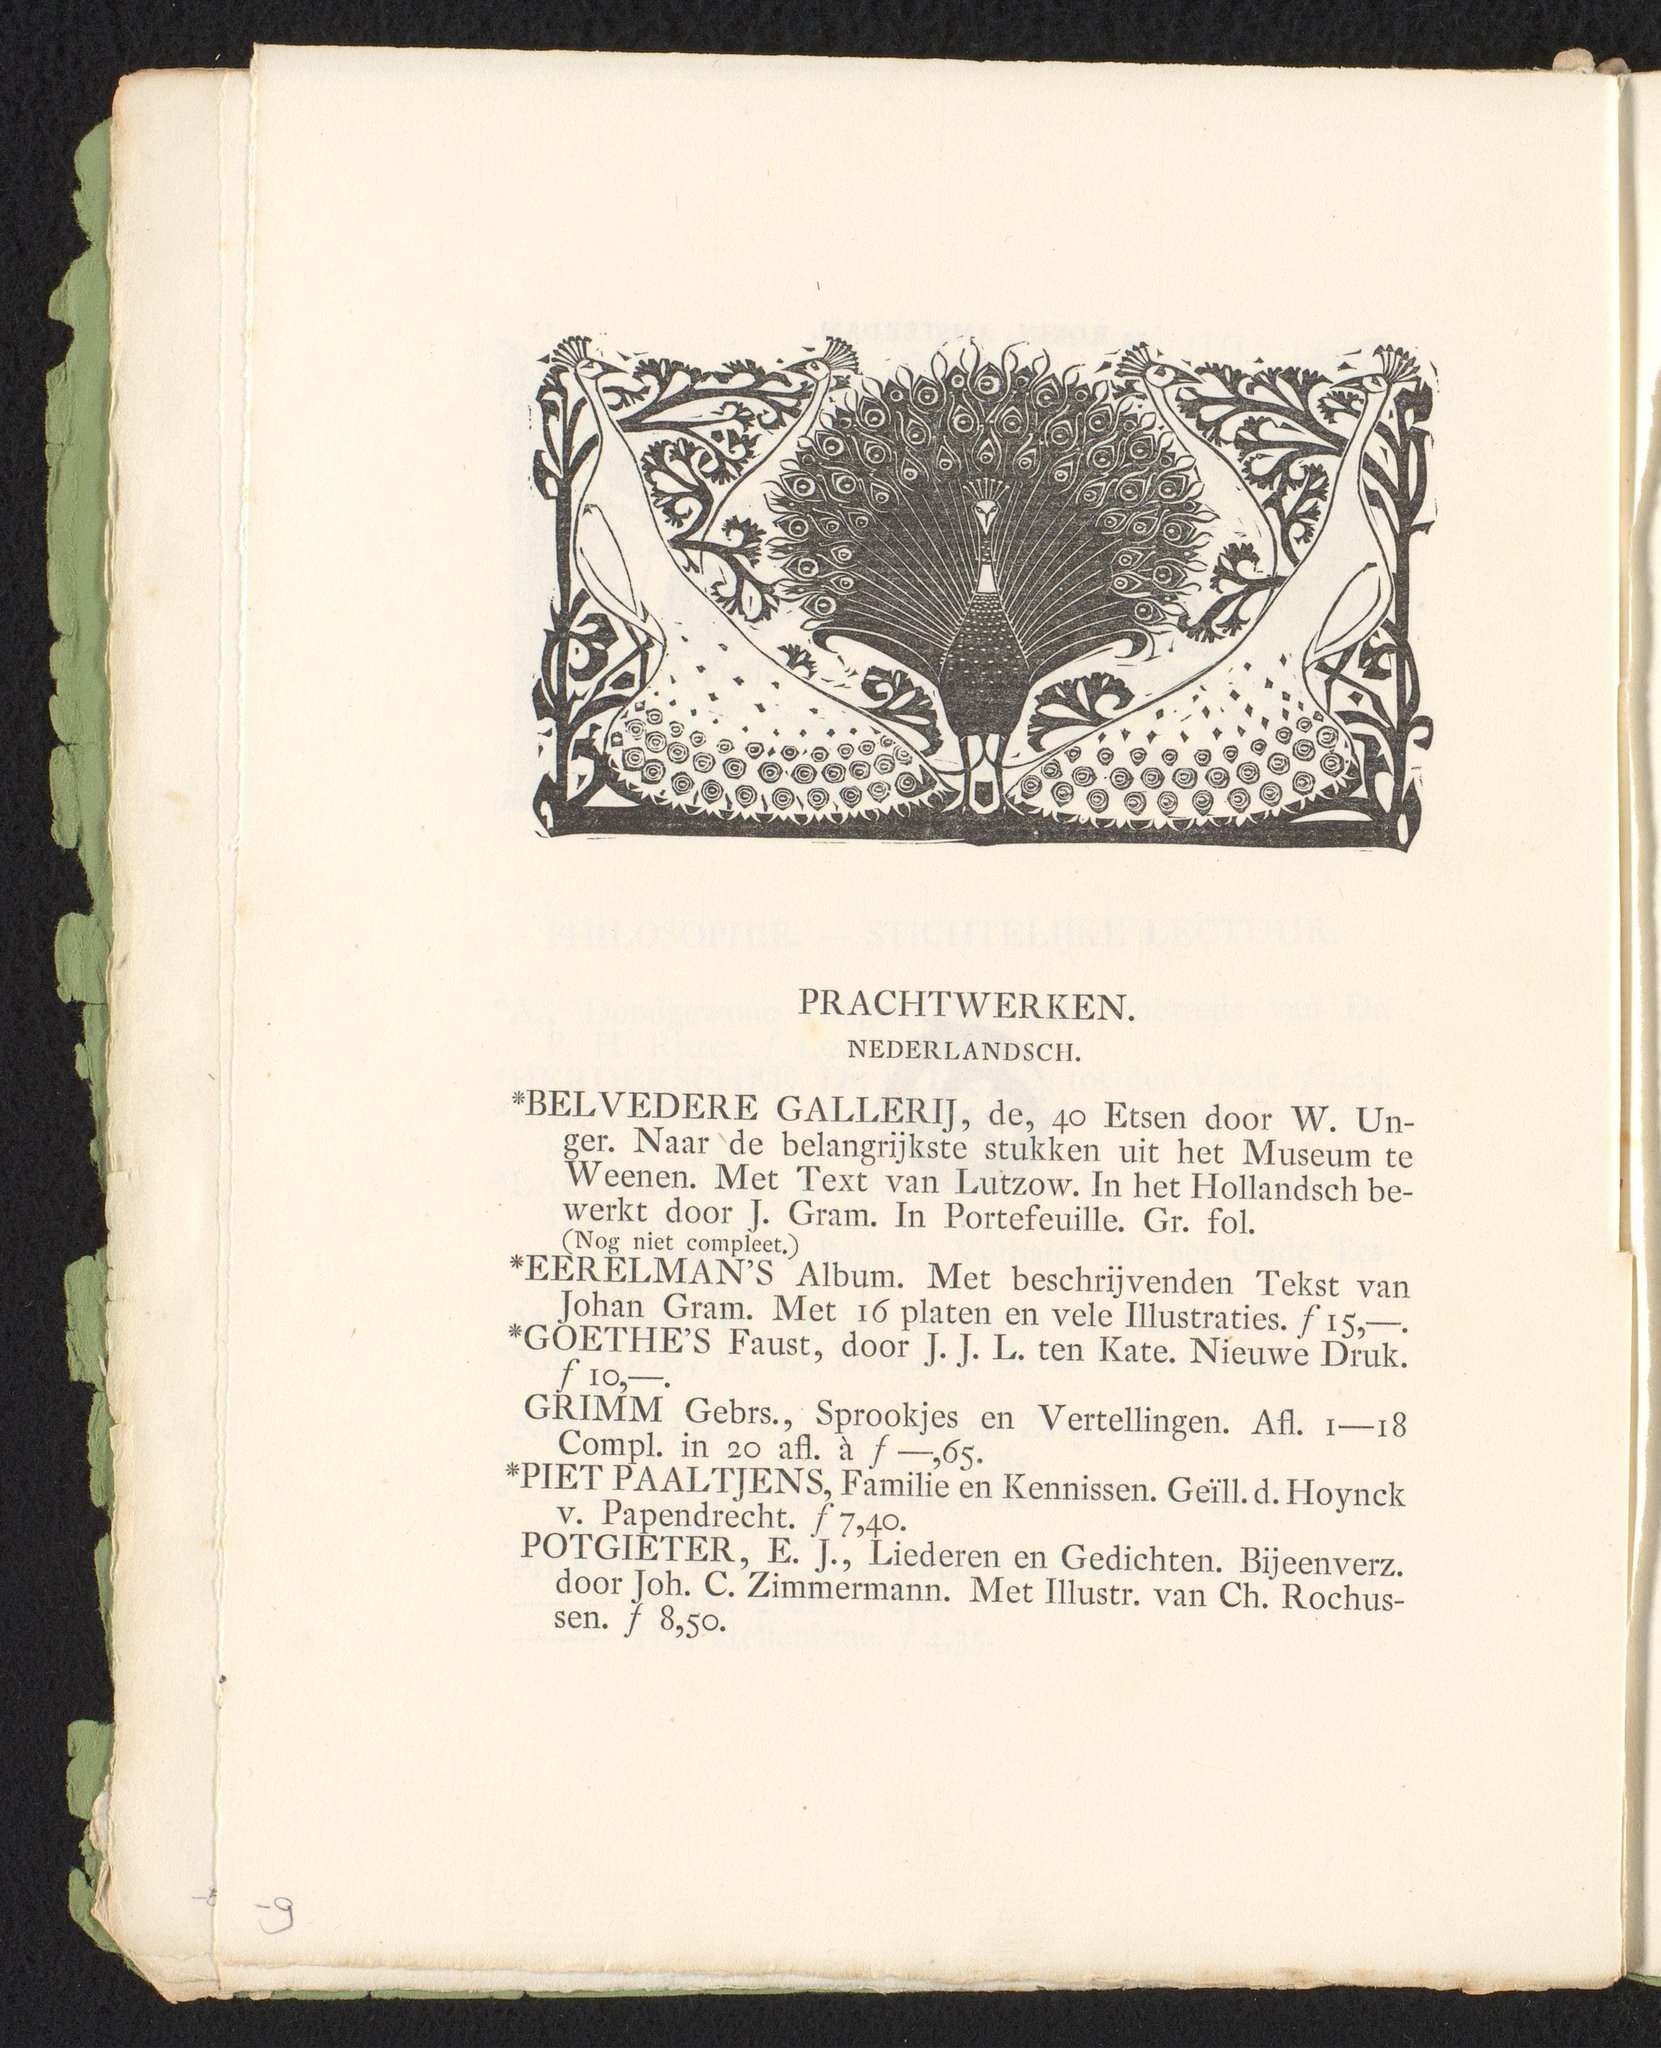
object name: print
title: Titelhoofd met pauwen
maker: gerrit willem dijsselhof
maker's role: designer, draughtsman, print maker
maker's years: 1866-1924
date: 1893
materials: paper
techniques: letterpress printing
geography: amsterdam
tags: ornamental birds: peacock, ornament derived from plant forms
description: Prent uit: Catalogus van handboeken, pracht- en plaatwerken, dicht- en prozabundels en kinderliteratuur (...). Amsterdam: Scheltema & Holkema's Boekhandel, 1894, p. 12. Deze prent werd origineel ontworpen voor: Crane, Walter. Kunst en samenleving. [Vertaald uit het Engels door] Jan Veth. Amsterdam: Scheltema & Holkema's Boekhandel, 1894 [1893], voorafgaand aan de Inleiding.